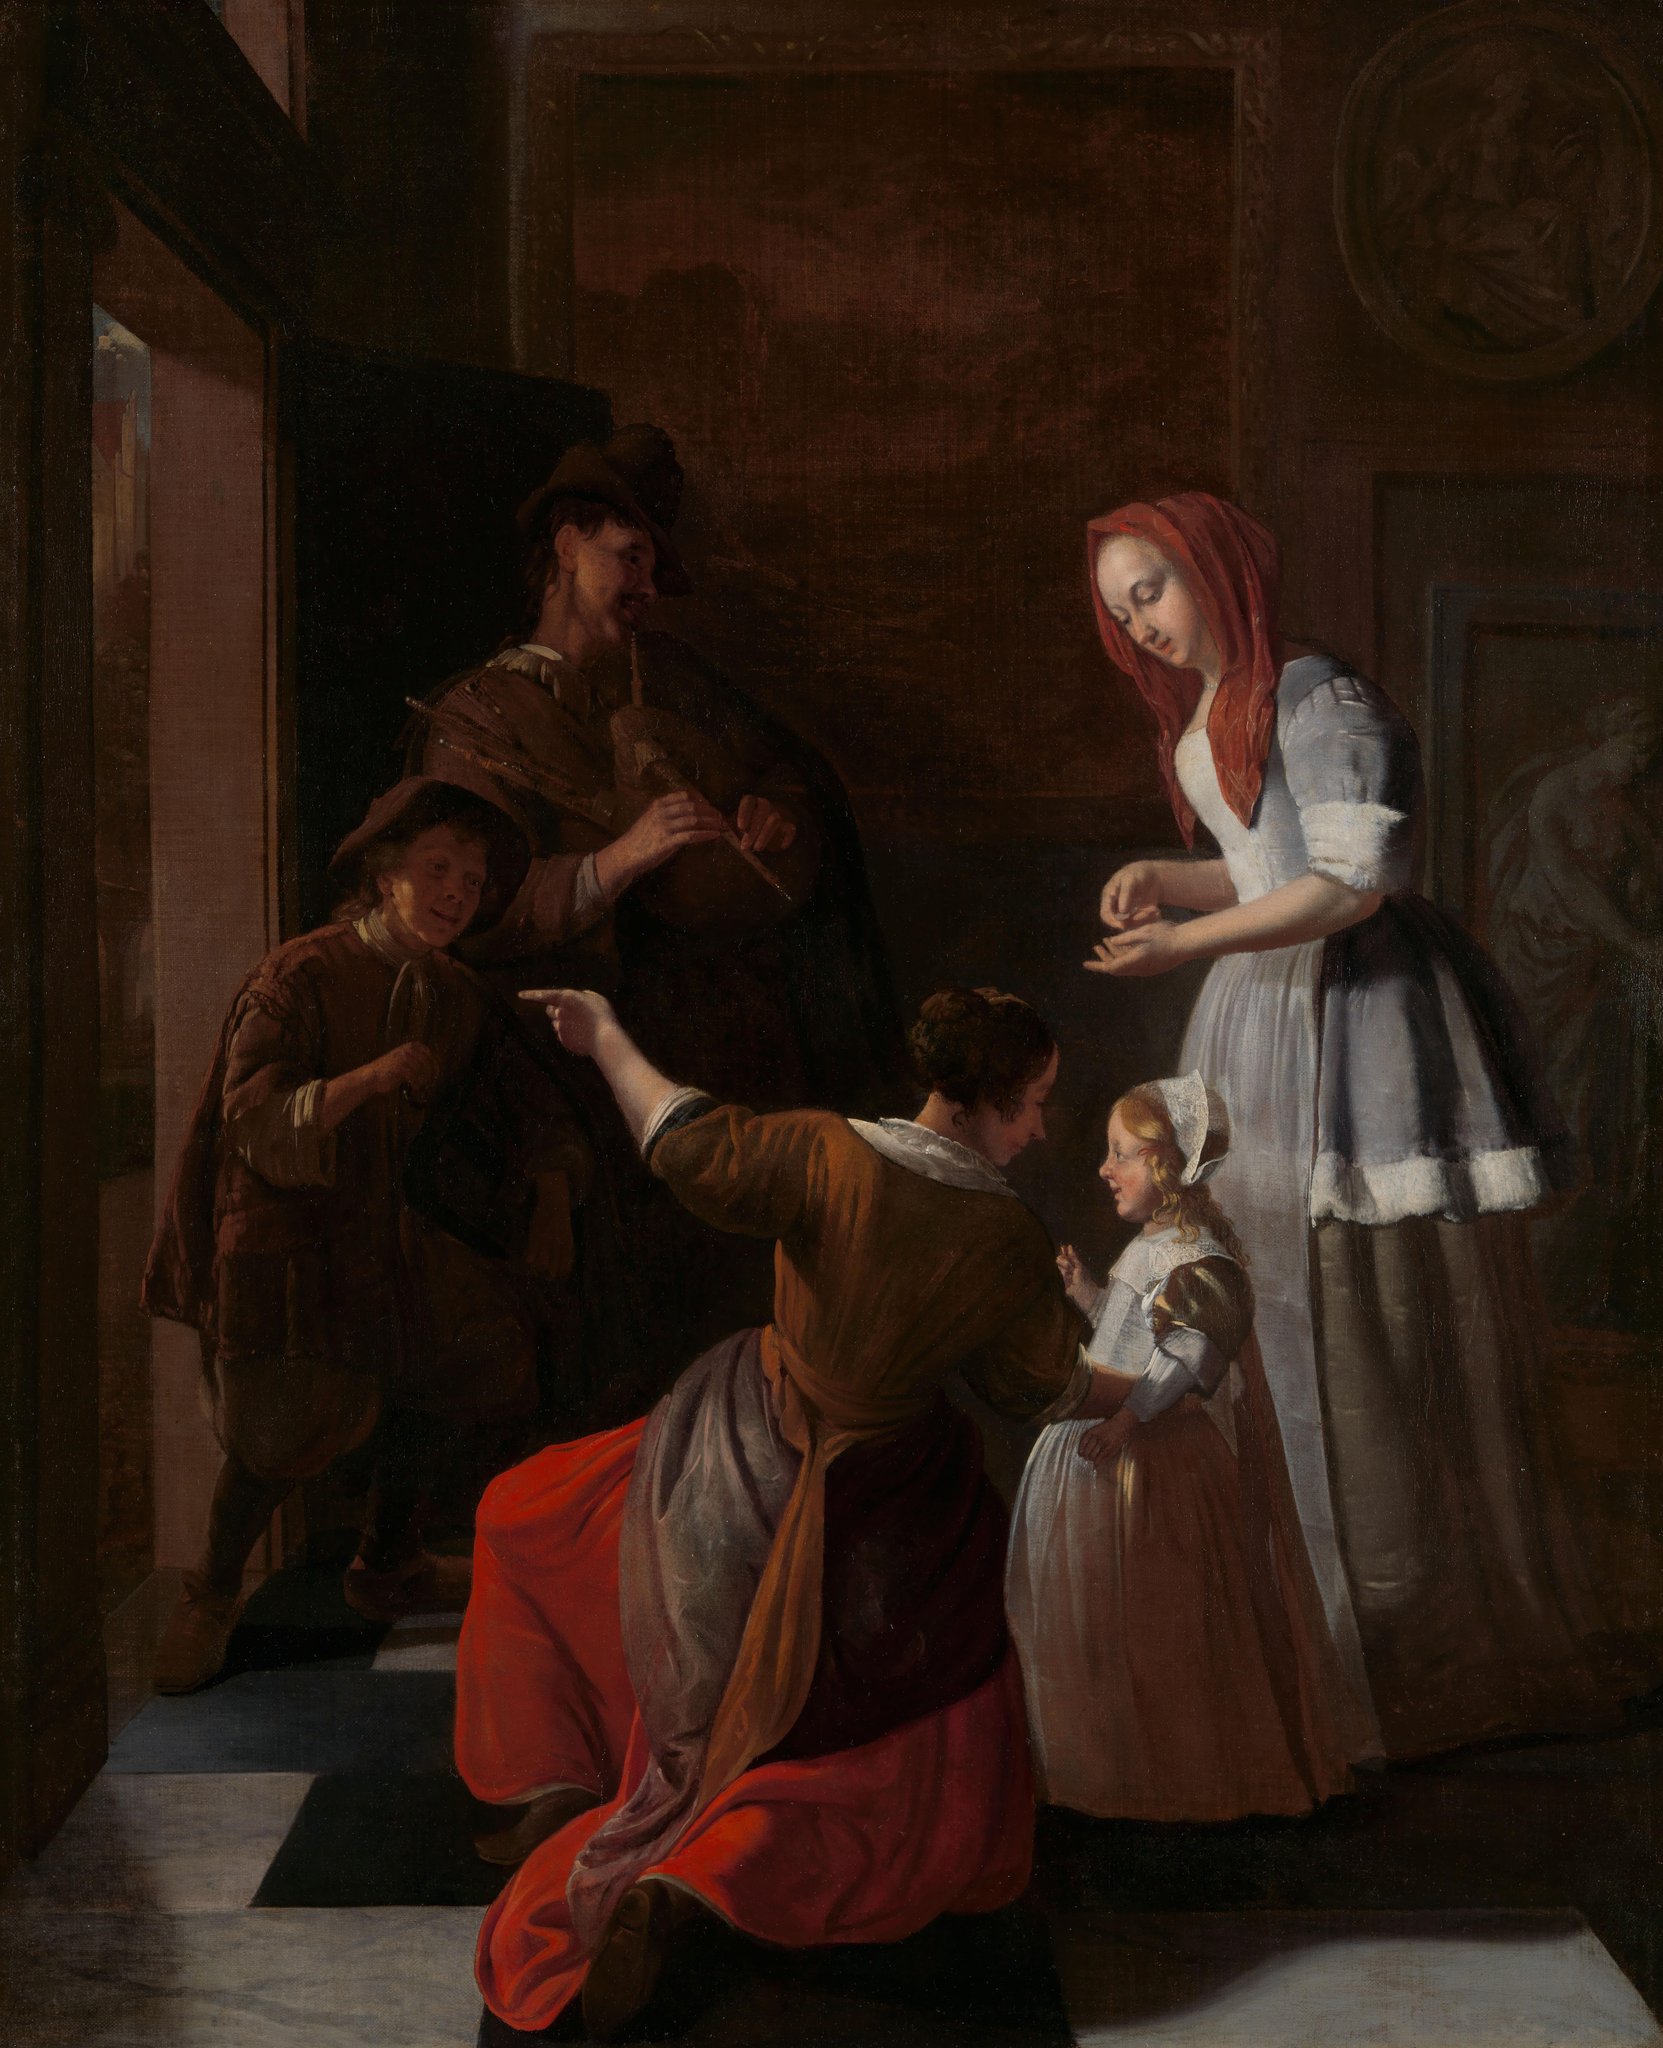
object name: painting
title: The players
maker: jacob ochtervelt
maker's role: painter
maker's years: 1634-1682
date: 1660-1682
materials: canvas, oil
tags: mother with daughter(s) (mother-love), music - cc - out of doors, bagpipe, musette, hurdy-gurdy player, instrumental popular music, maid ~ house personnel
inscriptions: signature: ‘Jac. Ochtervelt f.’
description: Twee muzikanten, een man met doedelzak en een jongen met draailier, spelen binnen de deur een wijsje voor een klein meisje met haar moeder en dienstmaagd. De moeder telt alvast enkele geldstukken voor de speellieden. Aan de wand een groot schilderij van een landschap.